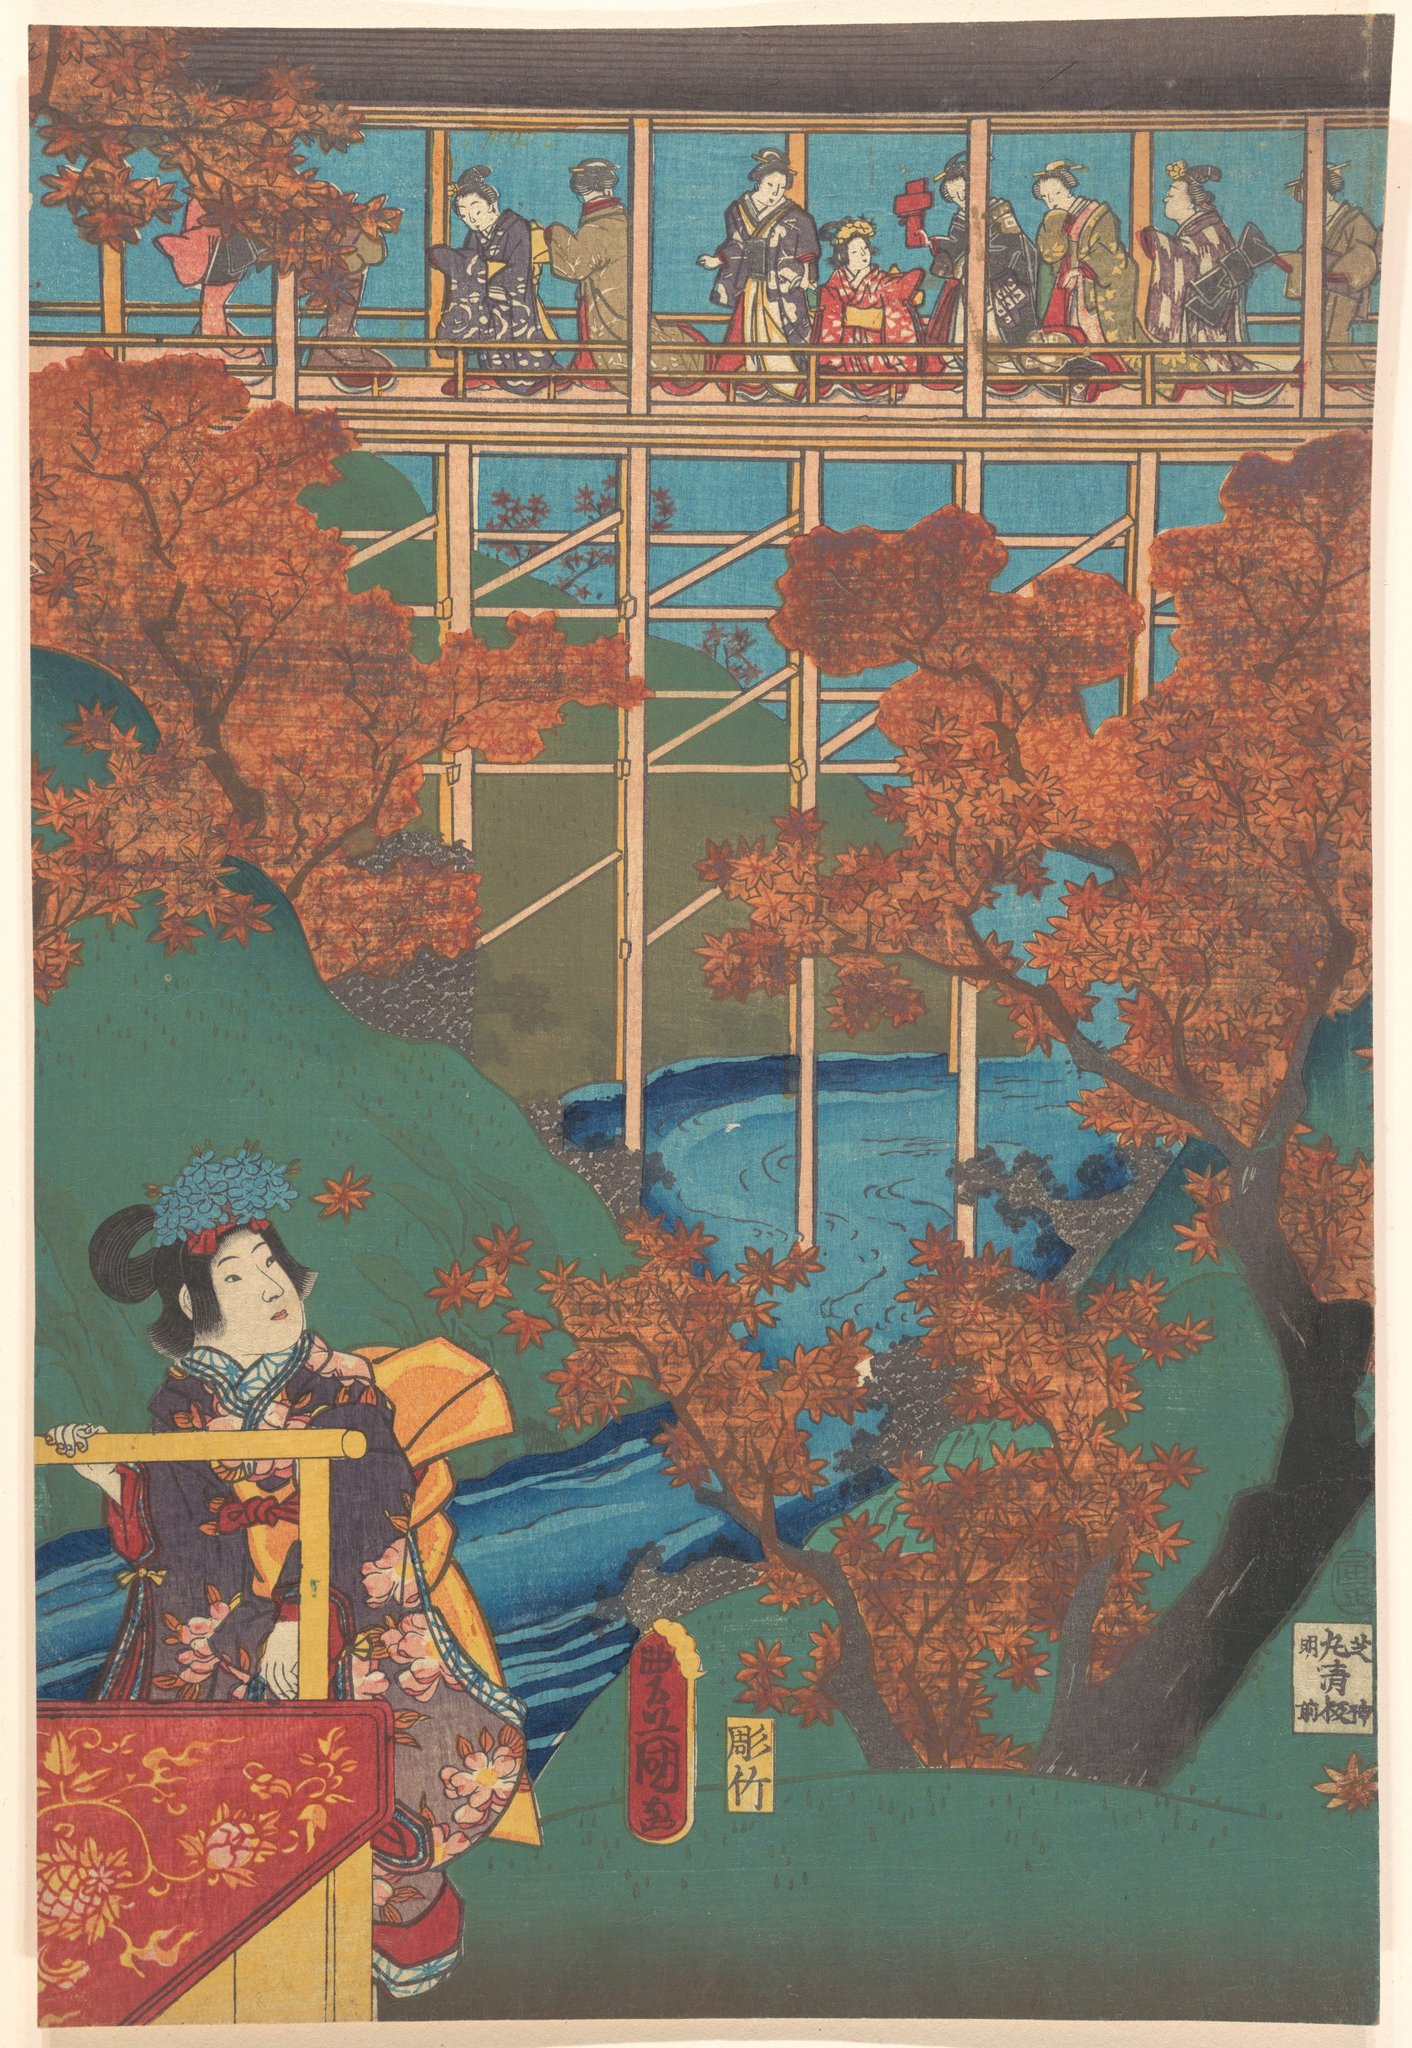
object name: print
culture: japanese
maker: utagawa kunisada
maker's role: artist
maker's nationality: japanese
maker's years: 1786-1864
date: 1786-1854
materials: ink, paper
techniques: woodblock print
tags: bridges,women